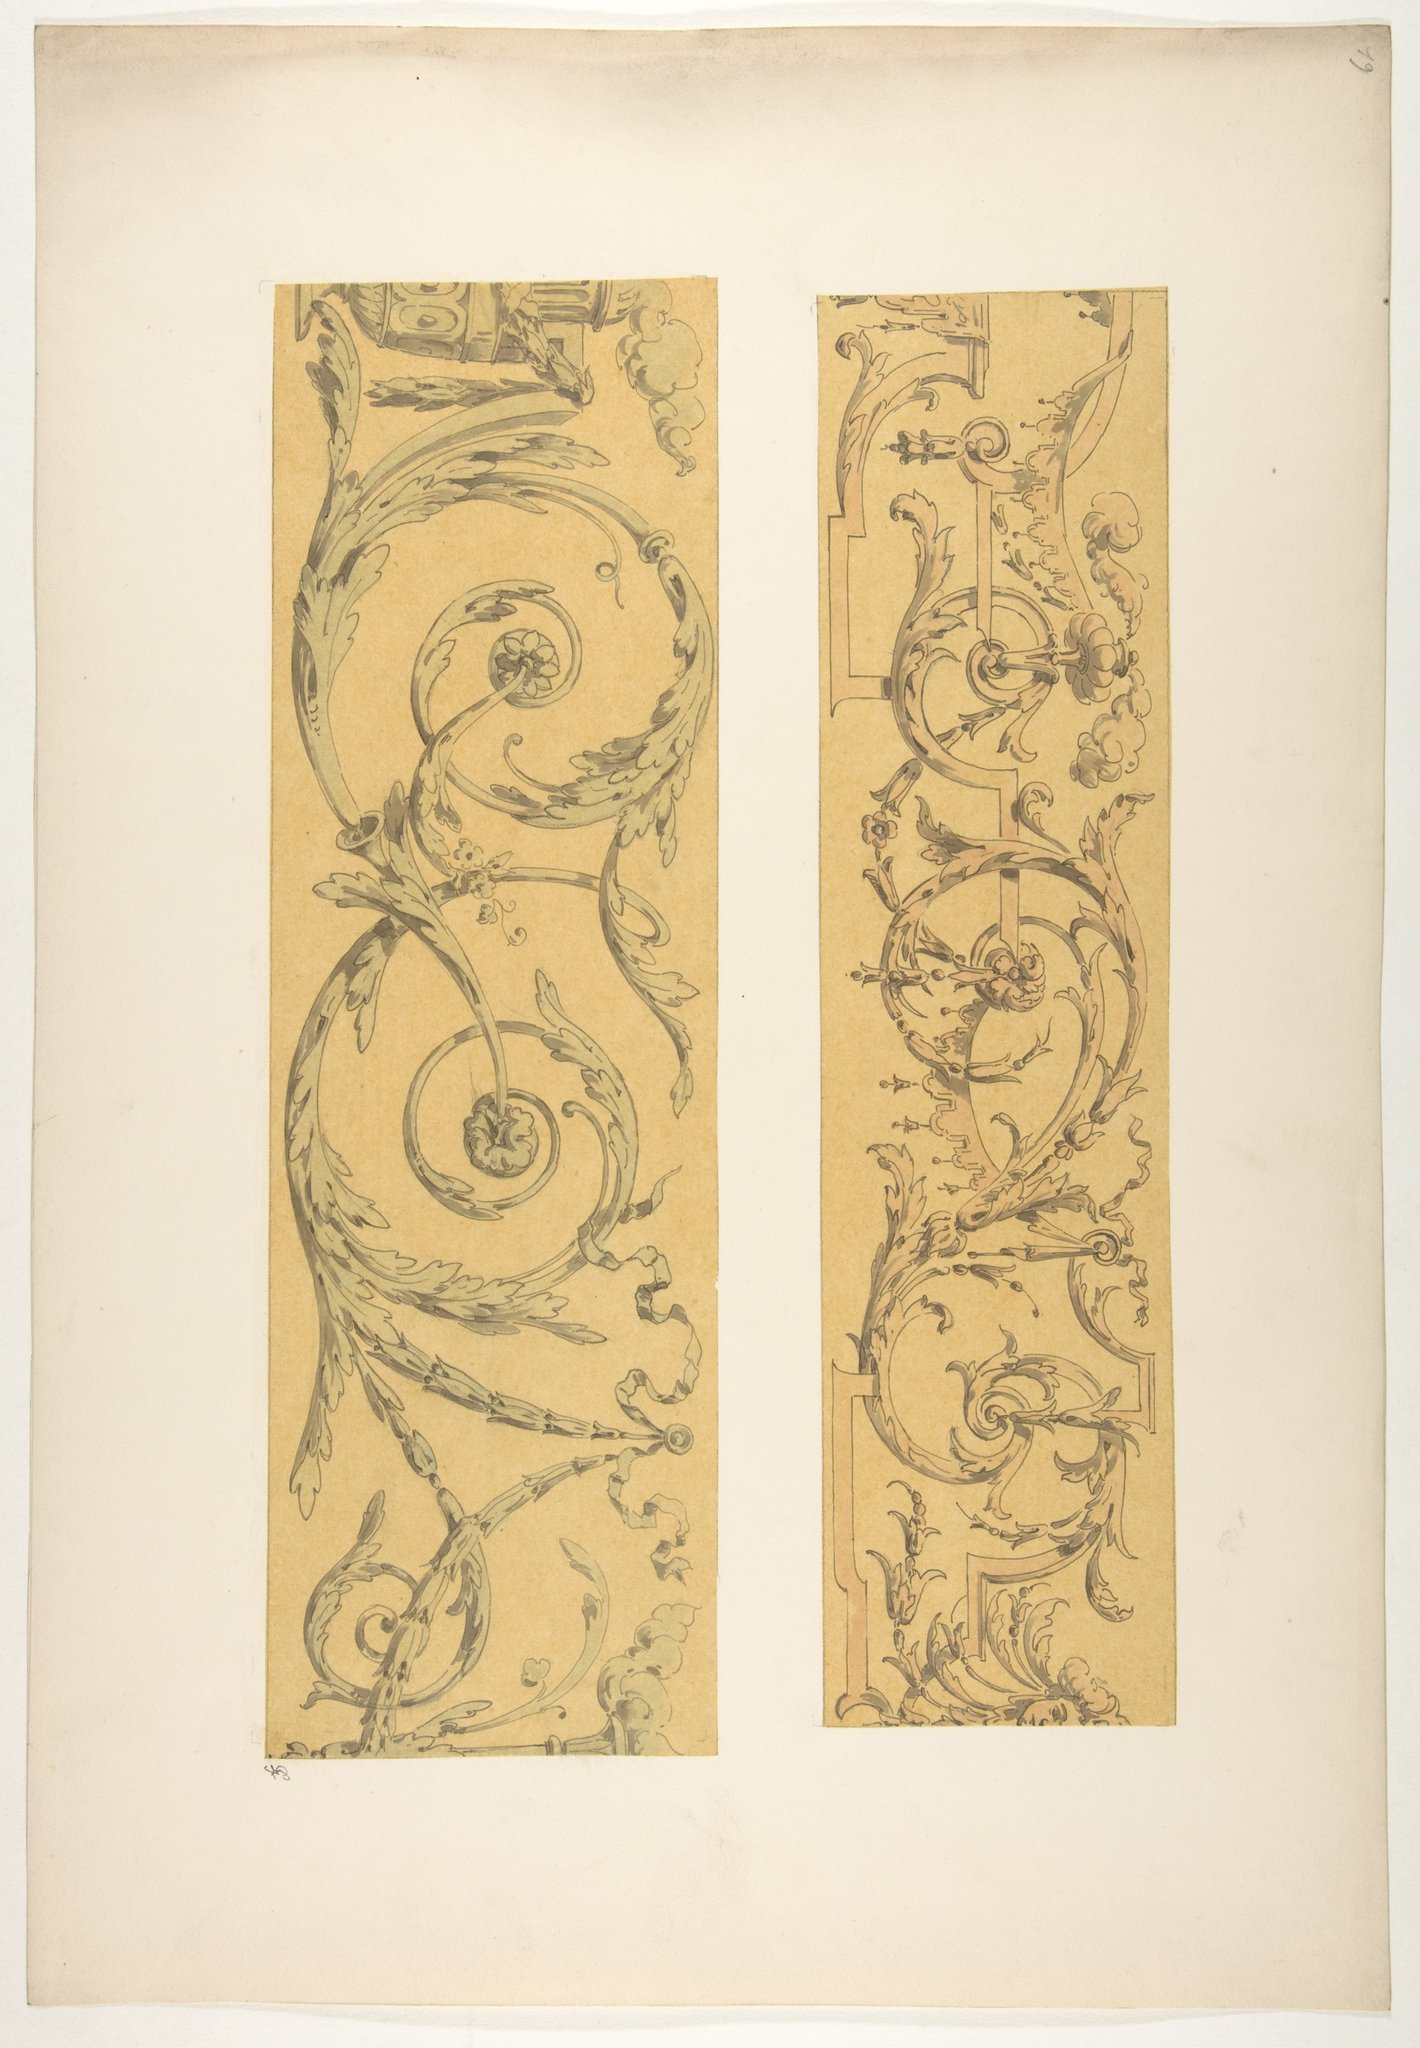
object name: drawing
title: Two designs for decorative borders in strapwork and rinceaux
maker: jules-edmond-charles lachaise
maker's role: artist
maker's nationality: french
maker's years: 1897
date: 1830-1897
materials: ink, paper, watercolor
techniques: pen, wash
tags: ornament